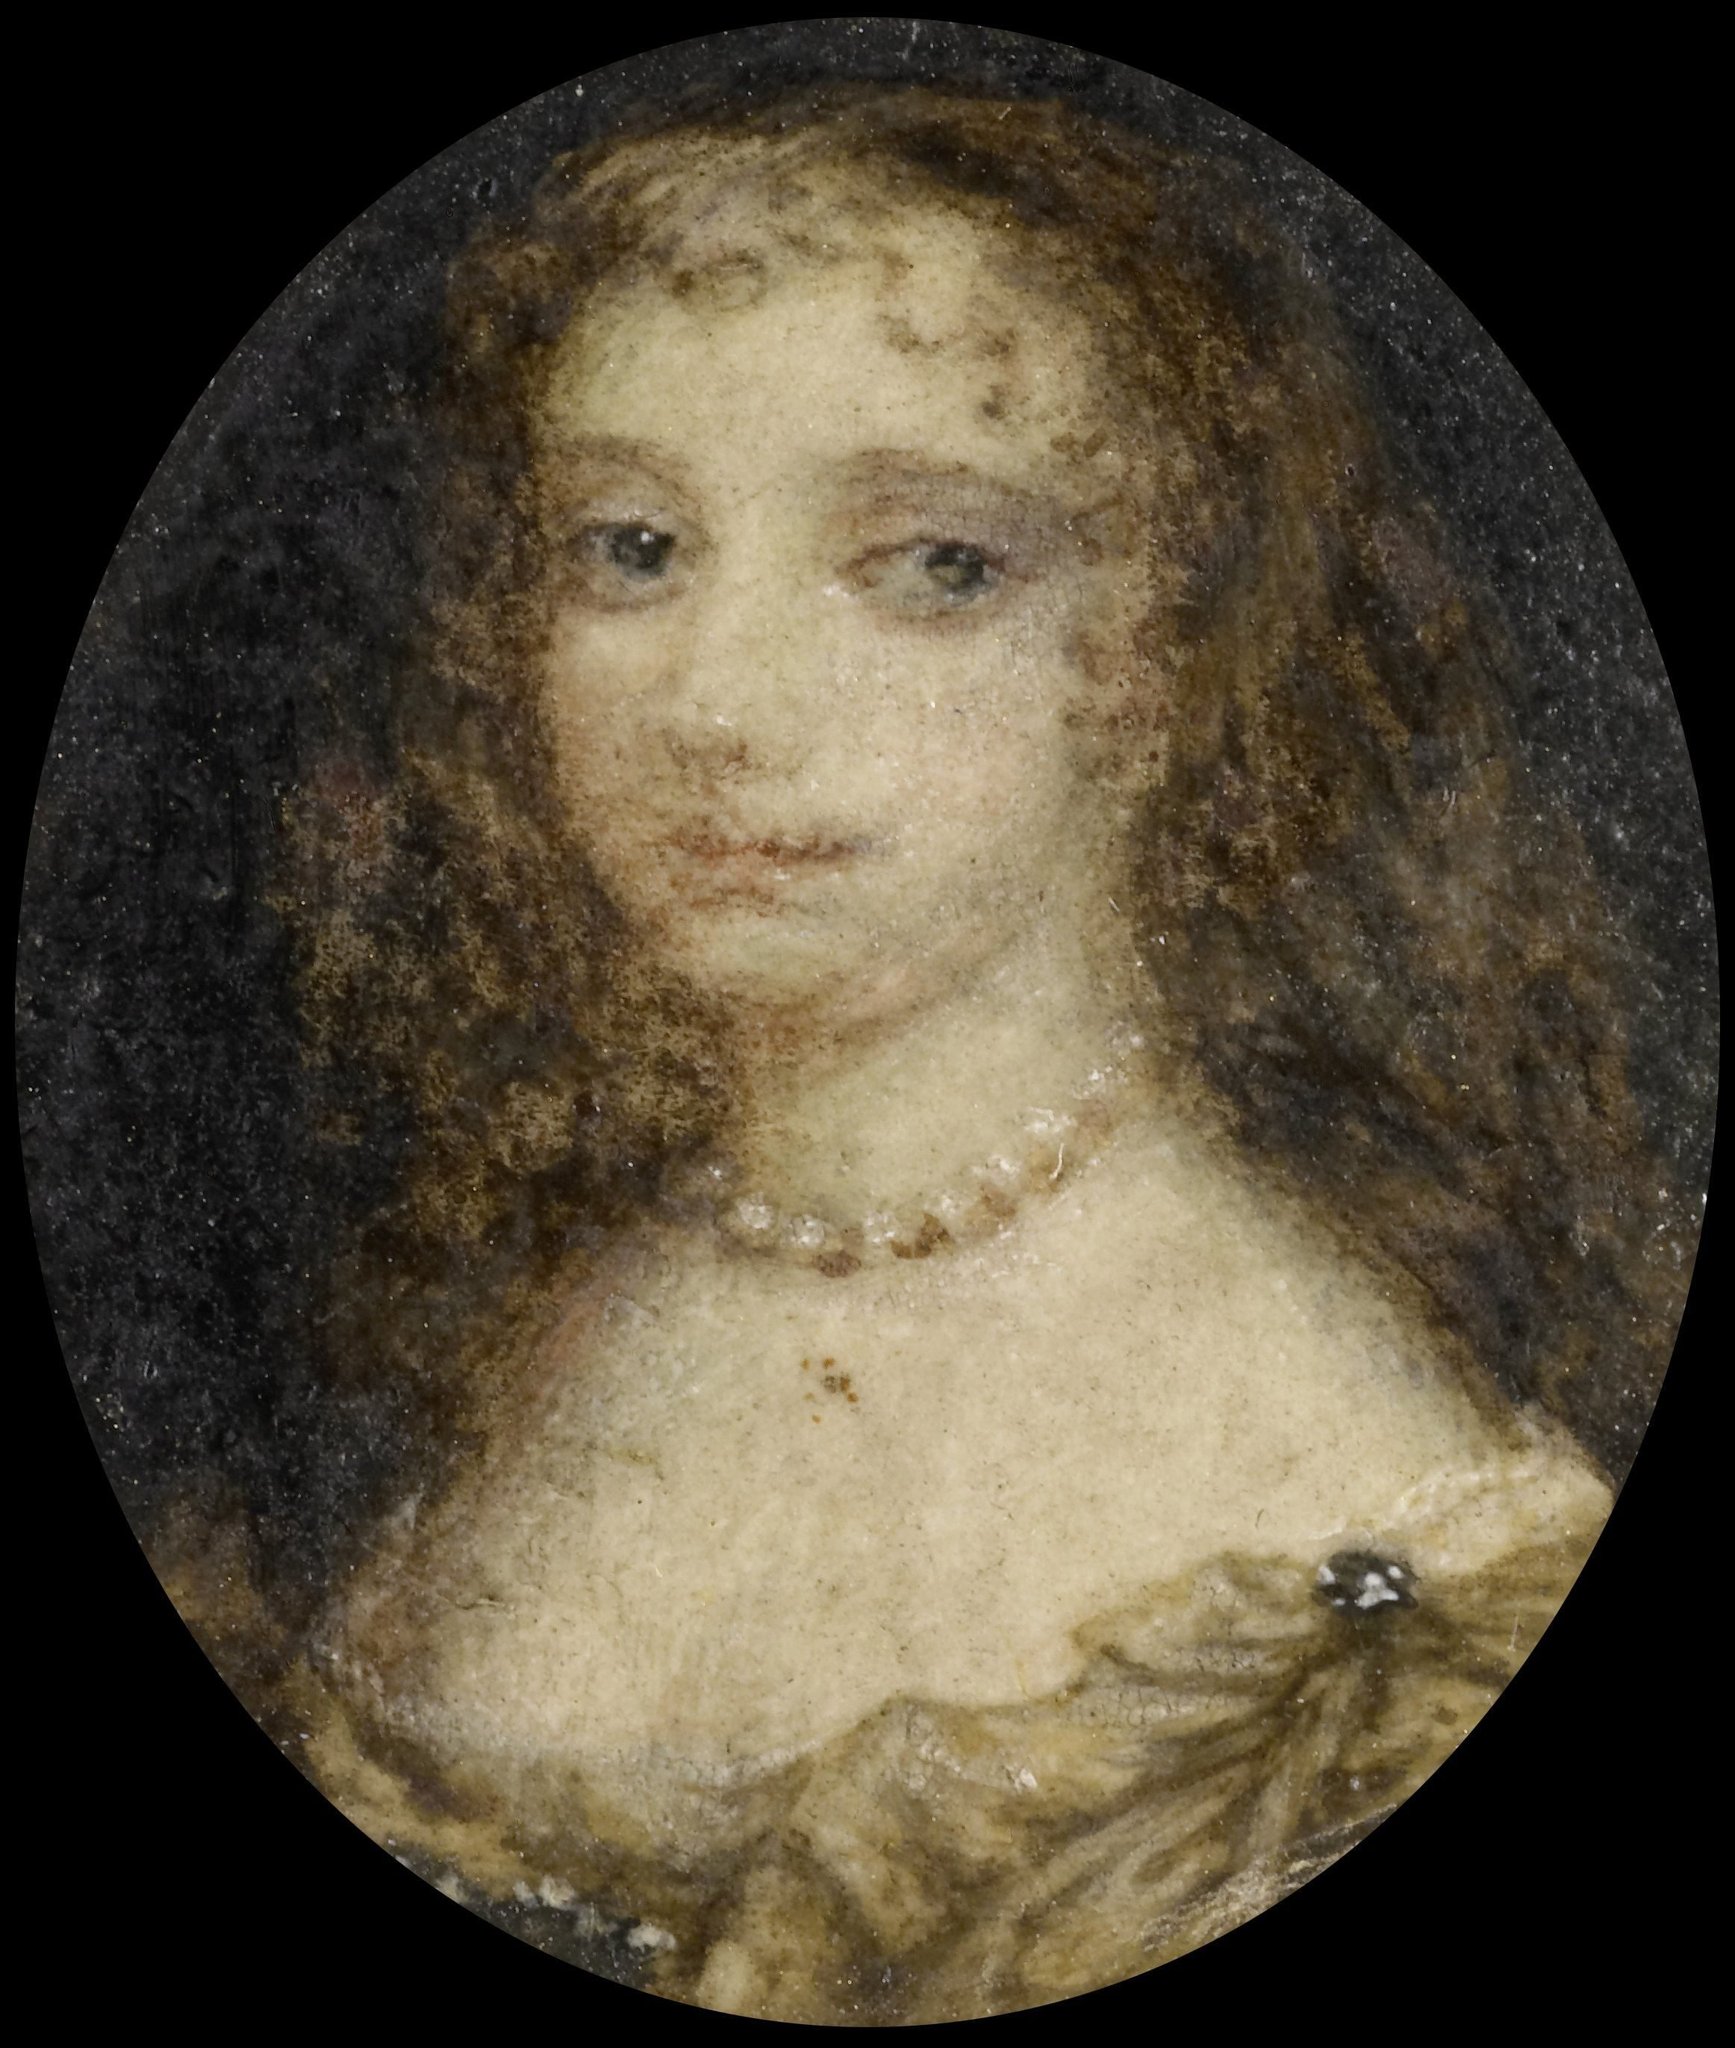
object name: painting, miniature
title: Portret van een vrouw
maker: Anonymous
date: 1665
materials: parchment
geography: england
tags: historical persons not known by name - bb - woman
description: Portret van een vrouw. Buste, naar links, aanziend. Onderdeel van de collectie portretminiaturen.